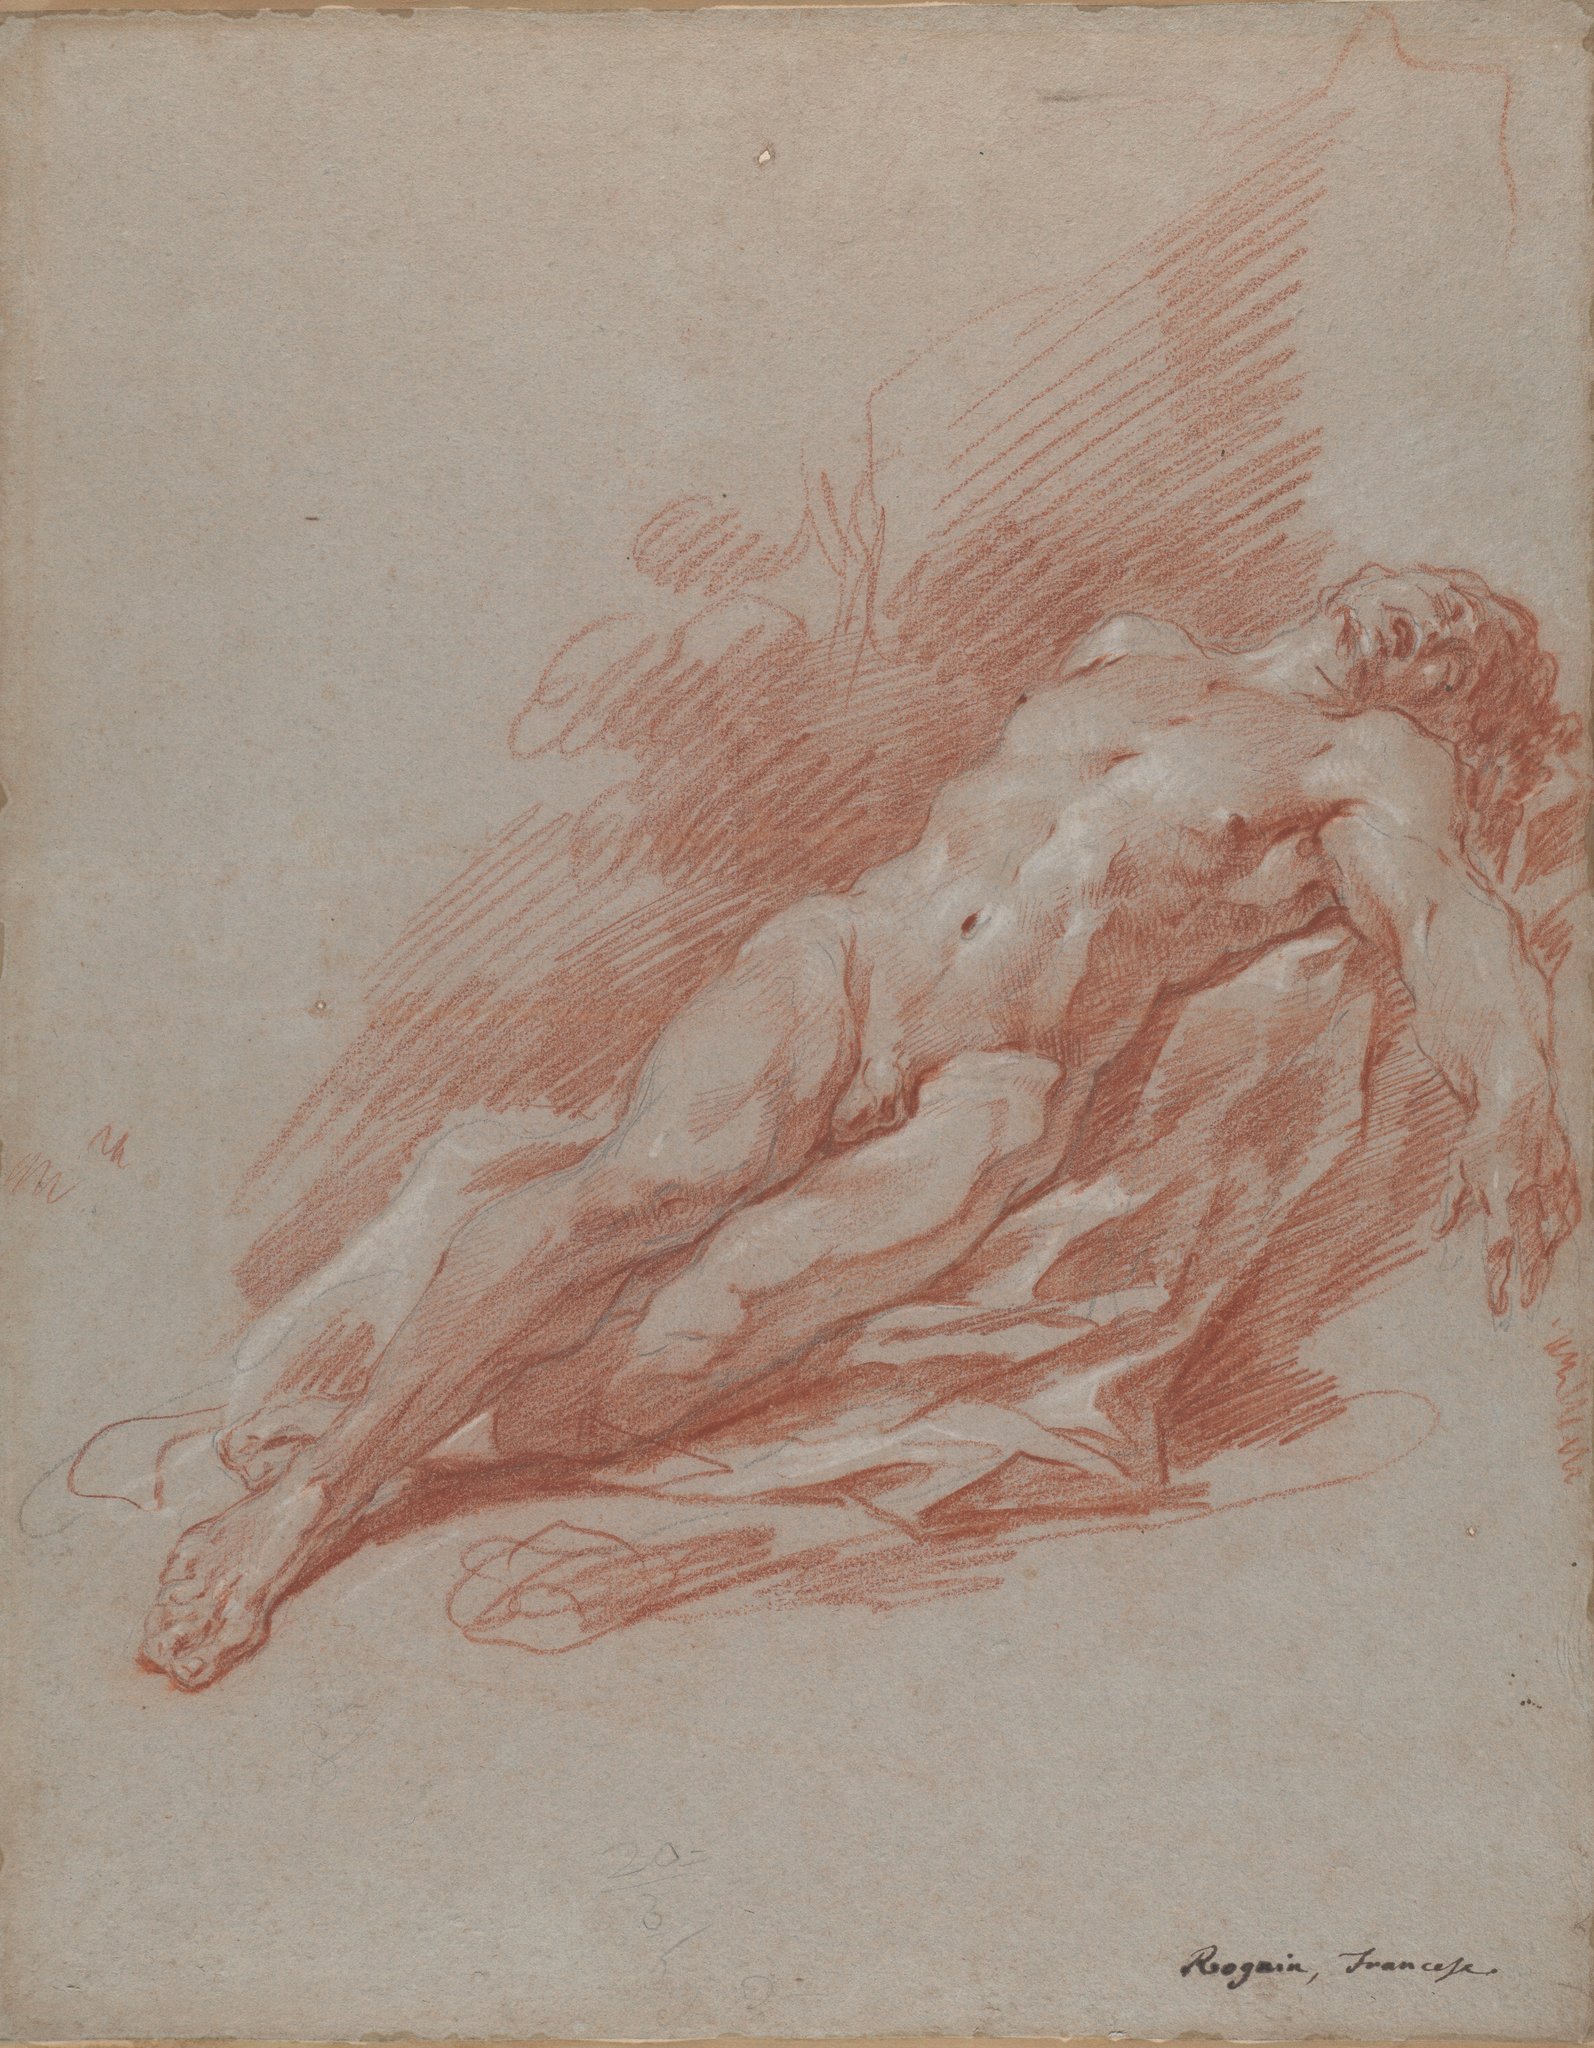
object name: drawing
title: Study of a Male Nude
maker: anonymous, french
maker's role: artist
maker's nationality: french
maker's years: 1400-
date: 1701-1800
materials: chalk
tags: male nudes